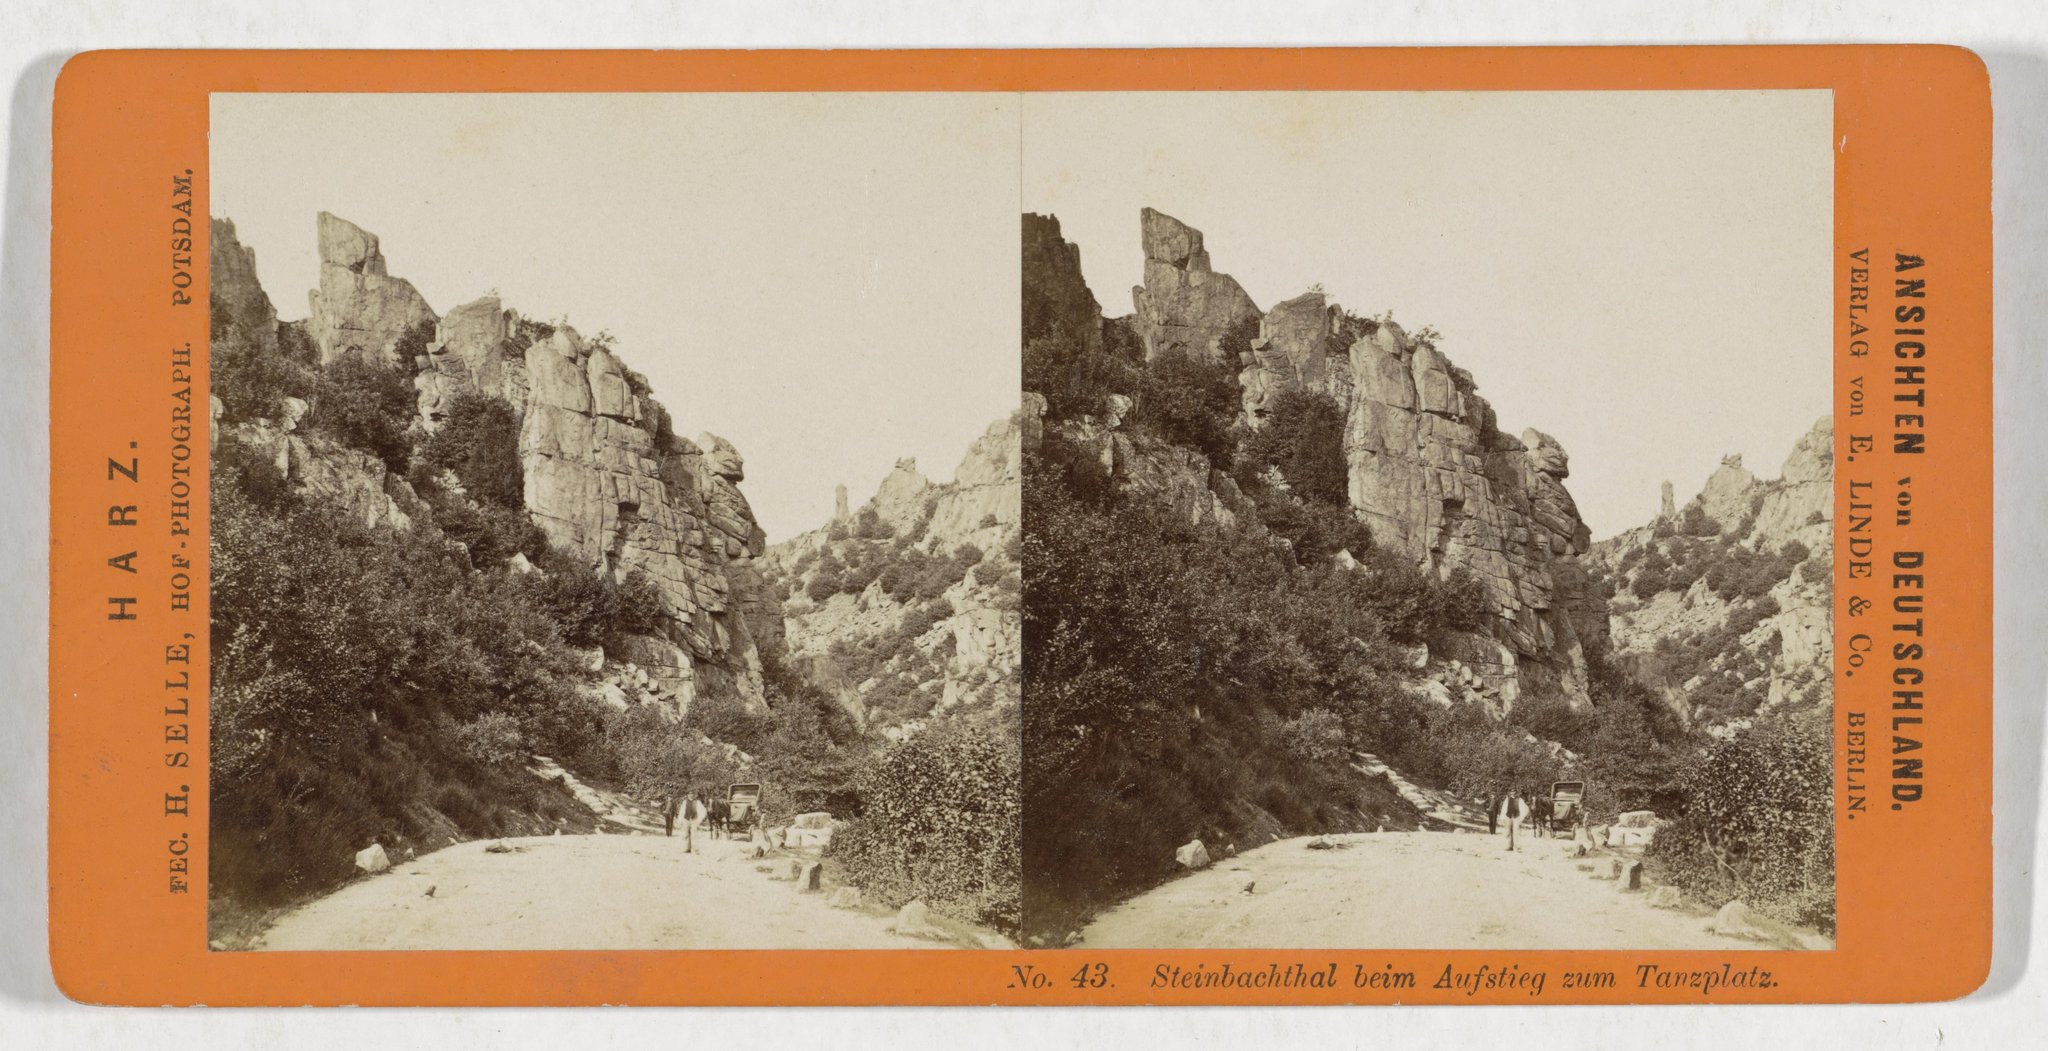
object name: stereograph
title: Steinbachthal beim Aufstieg zum Tanzplatz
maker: hermann selle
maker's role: fotograaf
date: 1868-1890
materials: cardboard, paper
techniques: albumen print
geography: hexentanzplatz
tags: rock-formations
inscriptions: inscription: ‘Hof-Photograph. Potsdam.’, number: ‘No. 43.’